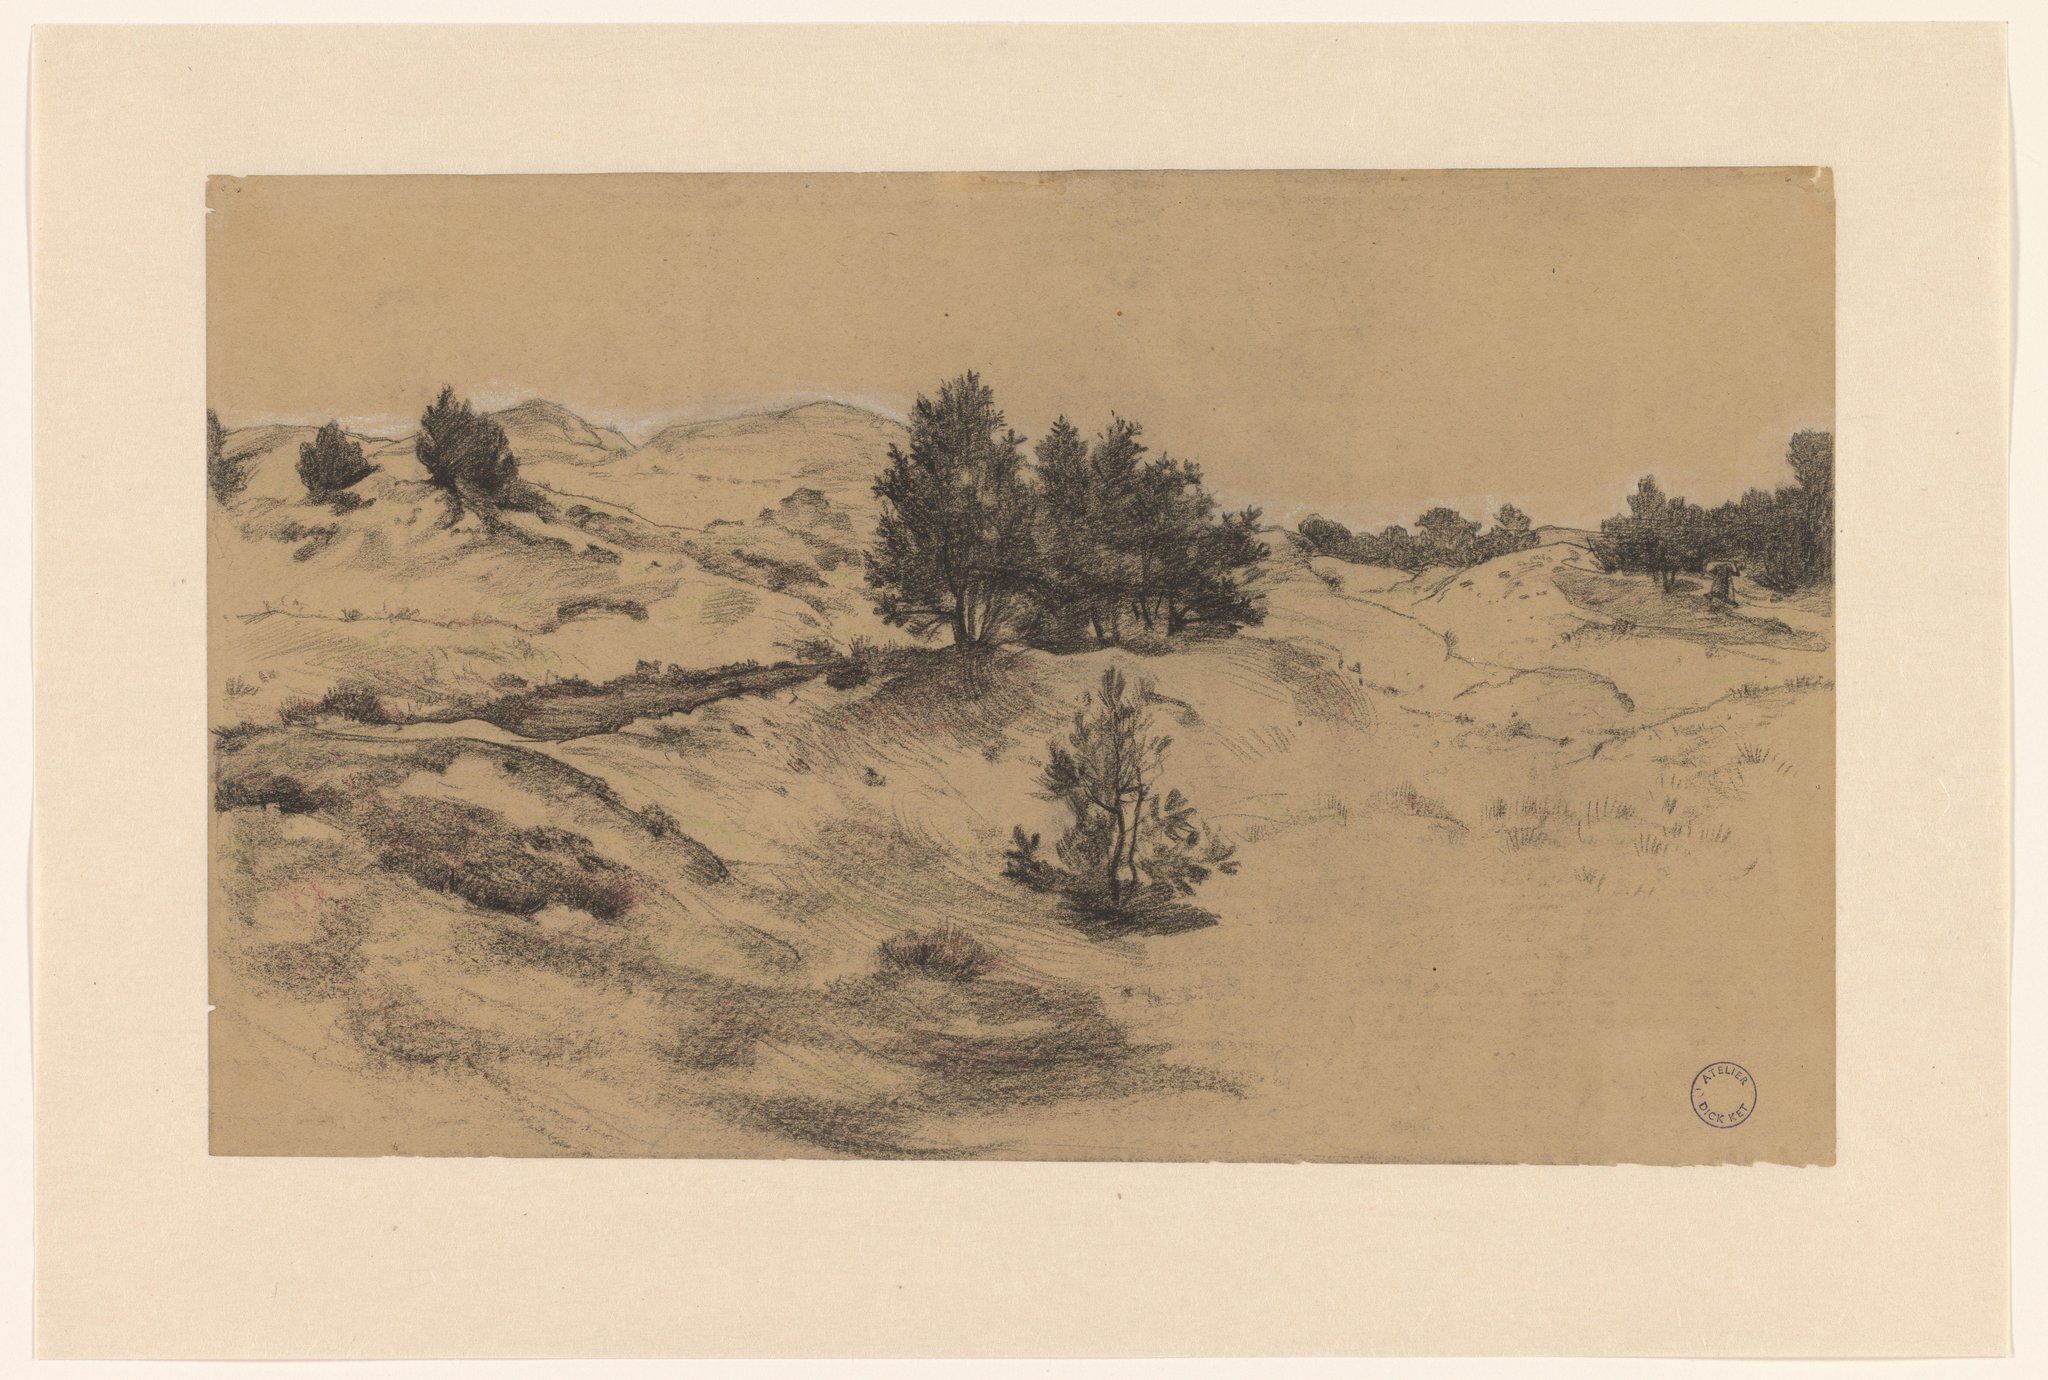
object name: drawing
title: Duinlandschap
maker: dick ket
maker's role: draughtsman, print maker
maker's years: 1902-1940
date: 1912-1940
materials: chalk, paper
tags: dunes (sea not visible); in the dunes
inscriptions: stamp: ‘Atelier Dick Ket’